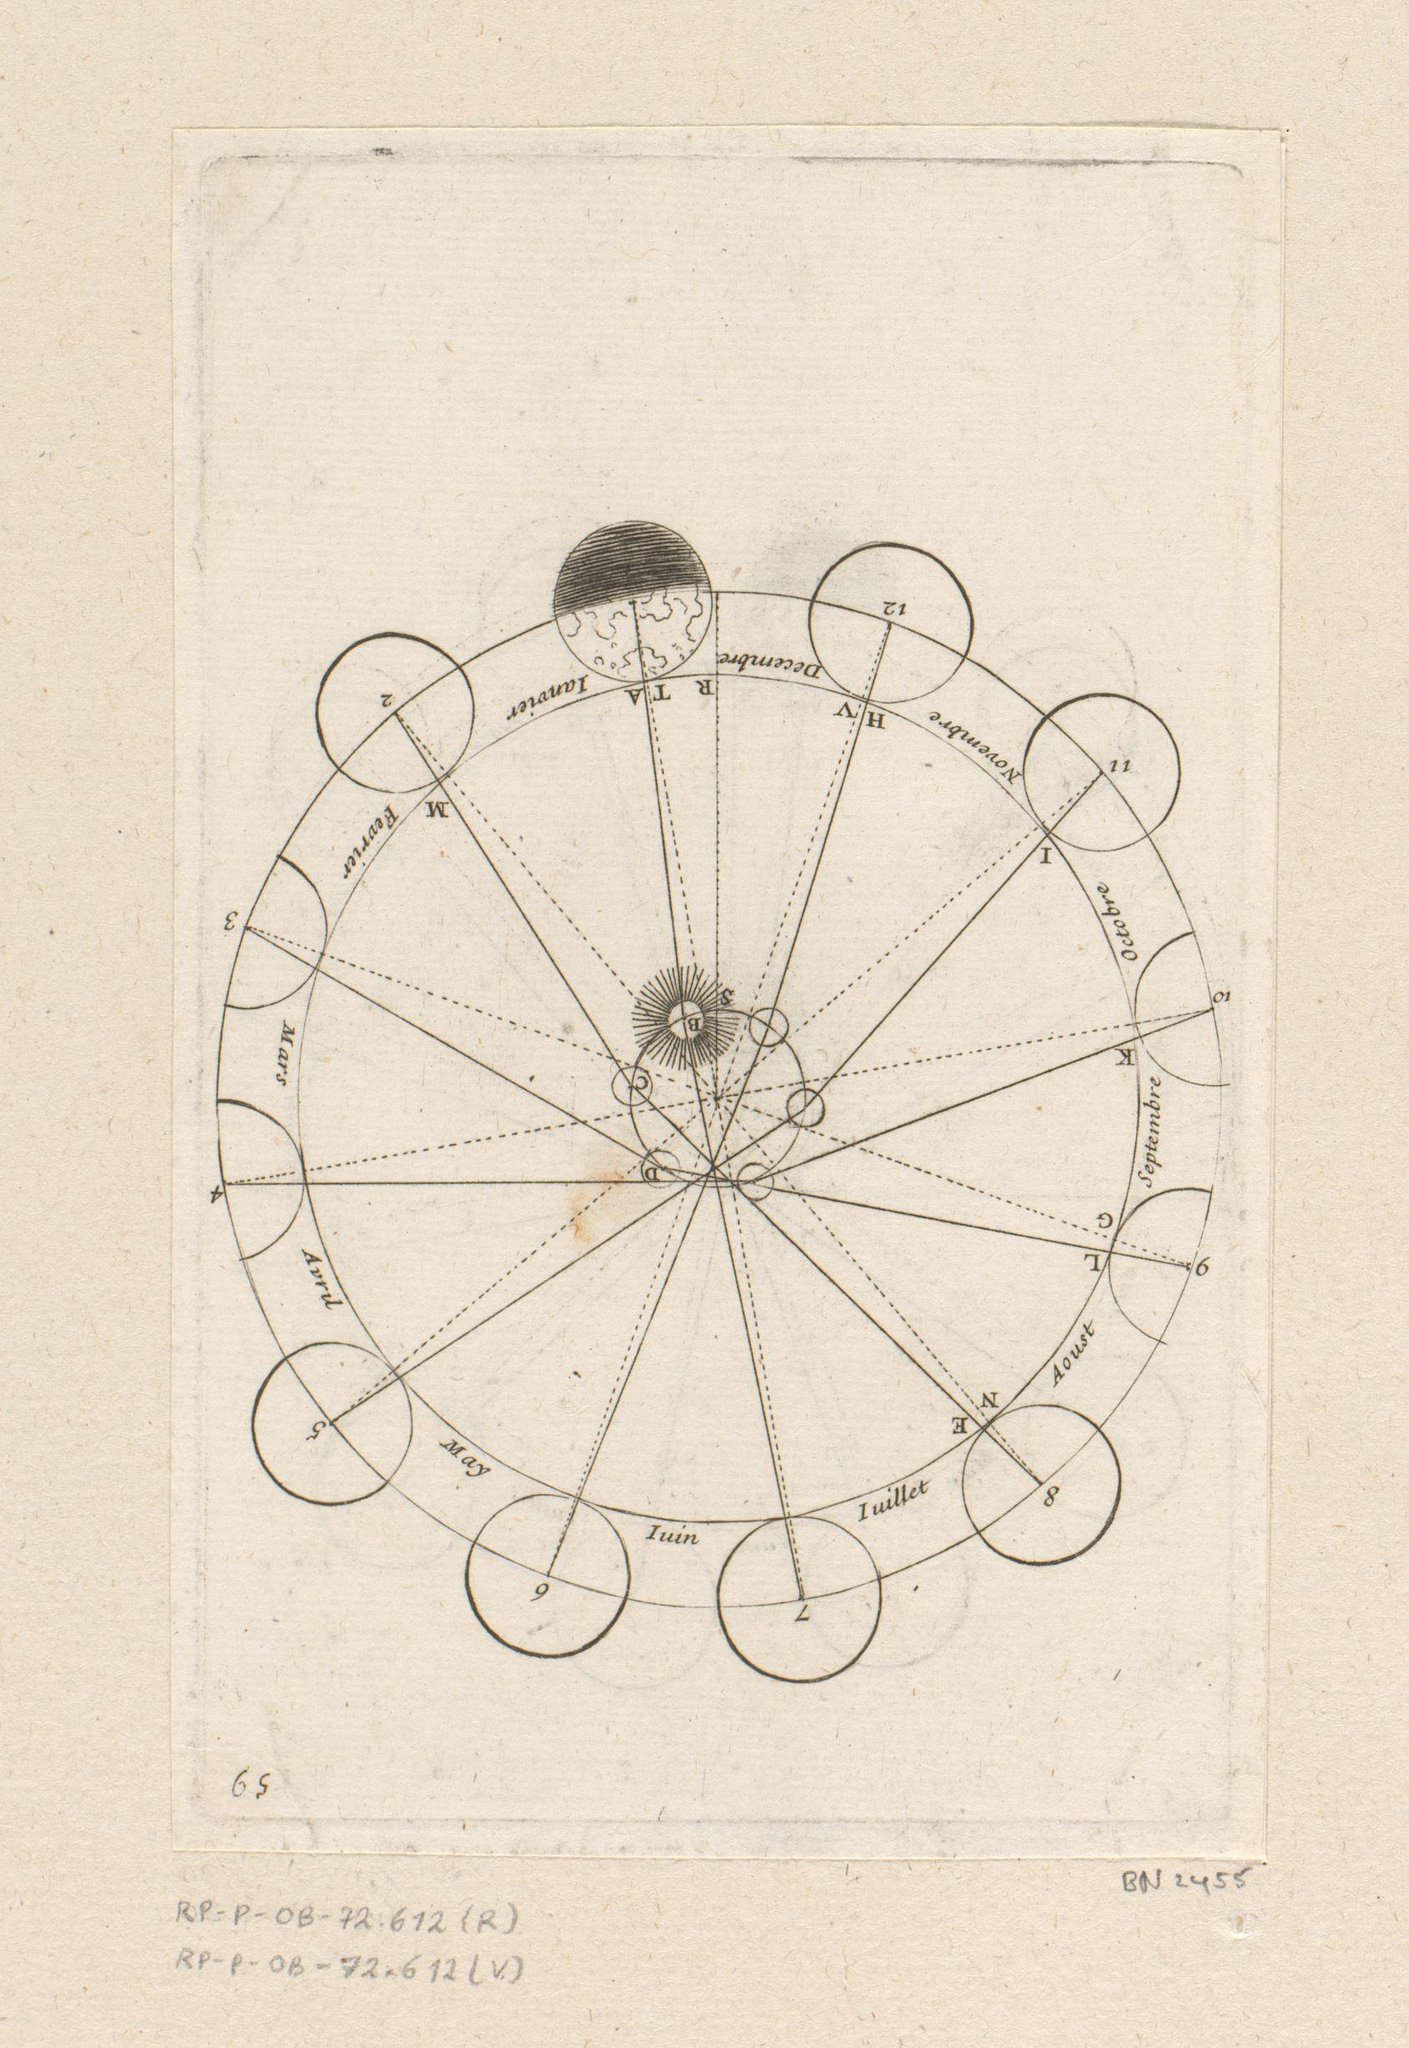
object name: print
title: Verhouding van de Zon tot de Aarde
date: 1706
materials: paper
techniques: etching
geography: france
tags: earth, world as celestial body, sun as celestial body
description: Prent uit: Leclerc, Sébastien. Nouveau systeme du monde conforme à l'Ecriture sainte. Où les phénomènes sont expliquez sans excentricité de mouvement (...). Paris: Pierre Giffart, 1706.